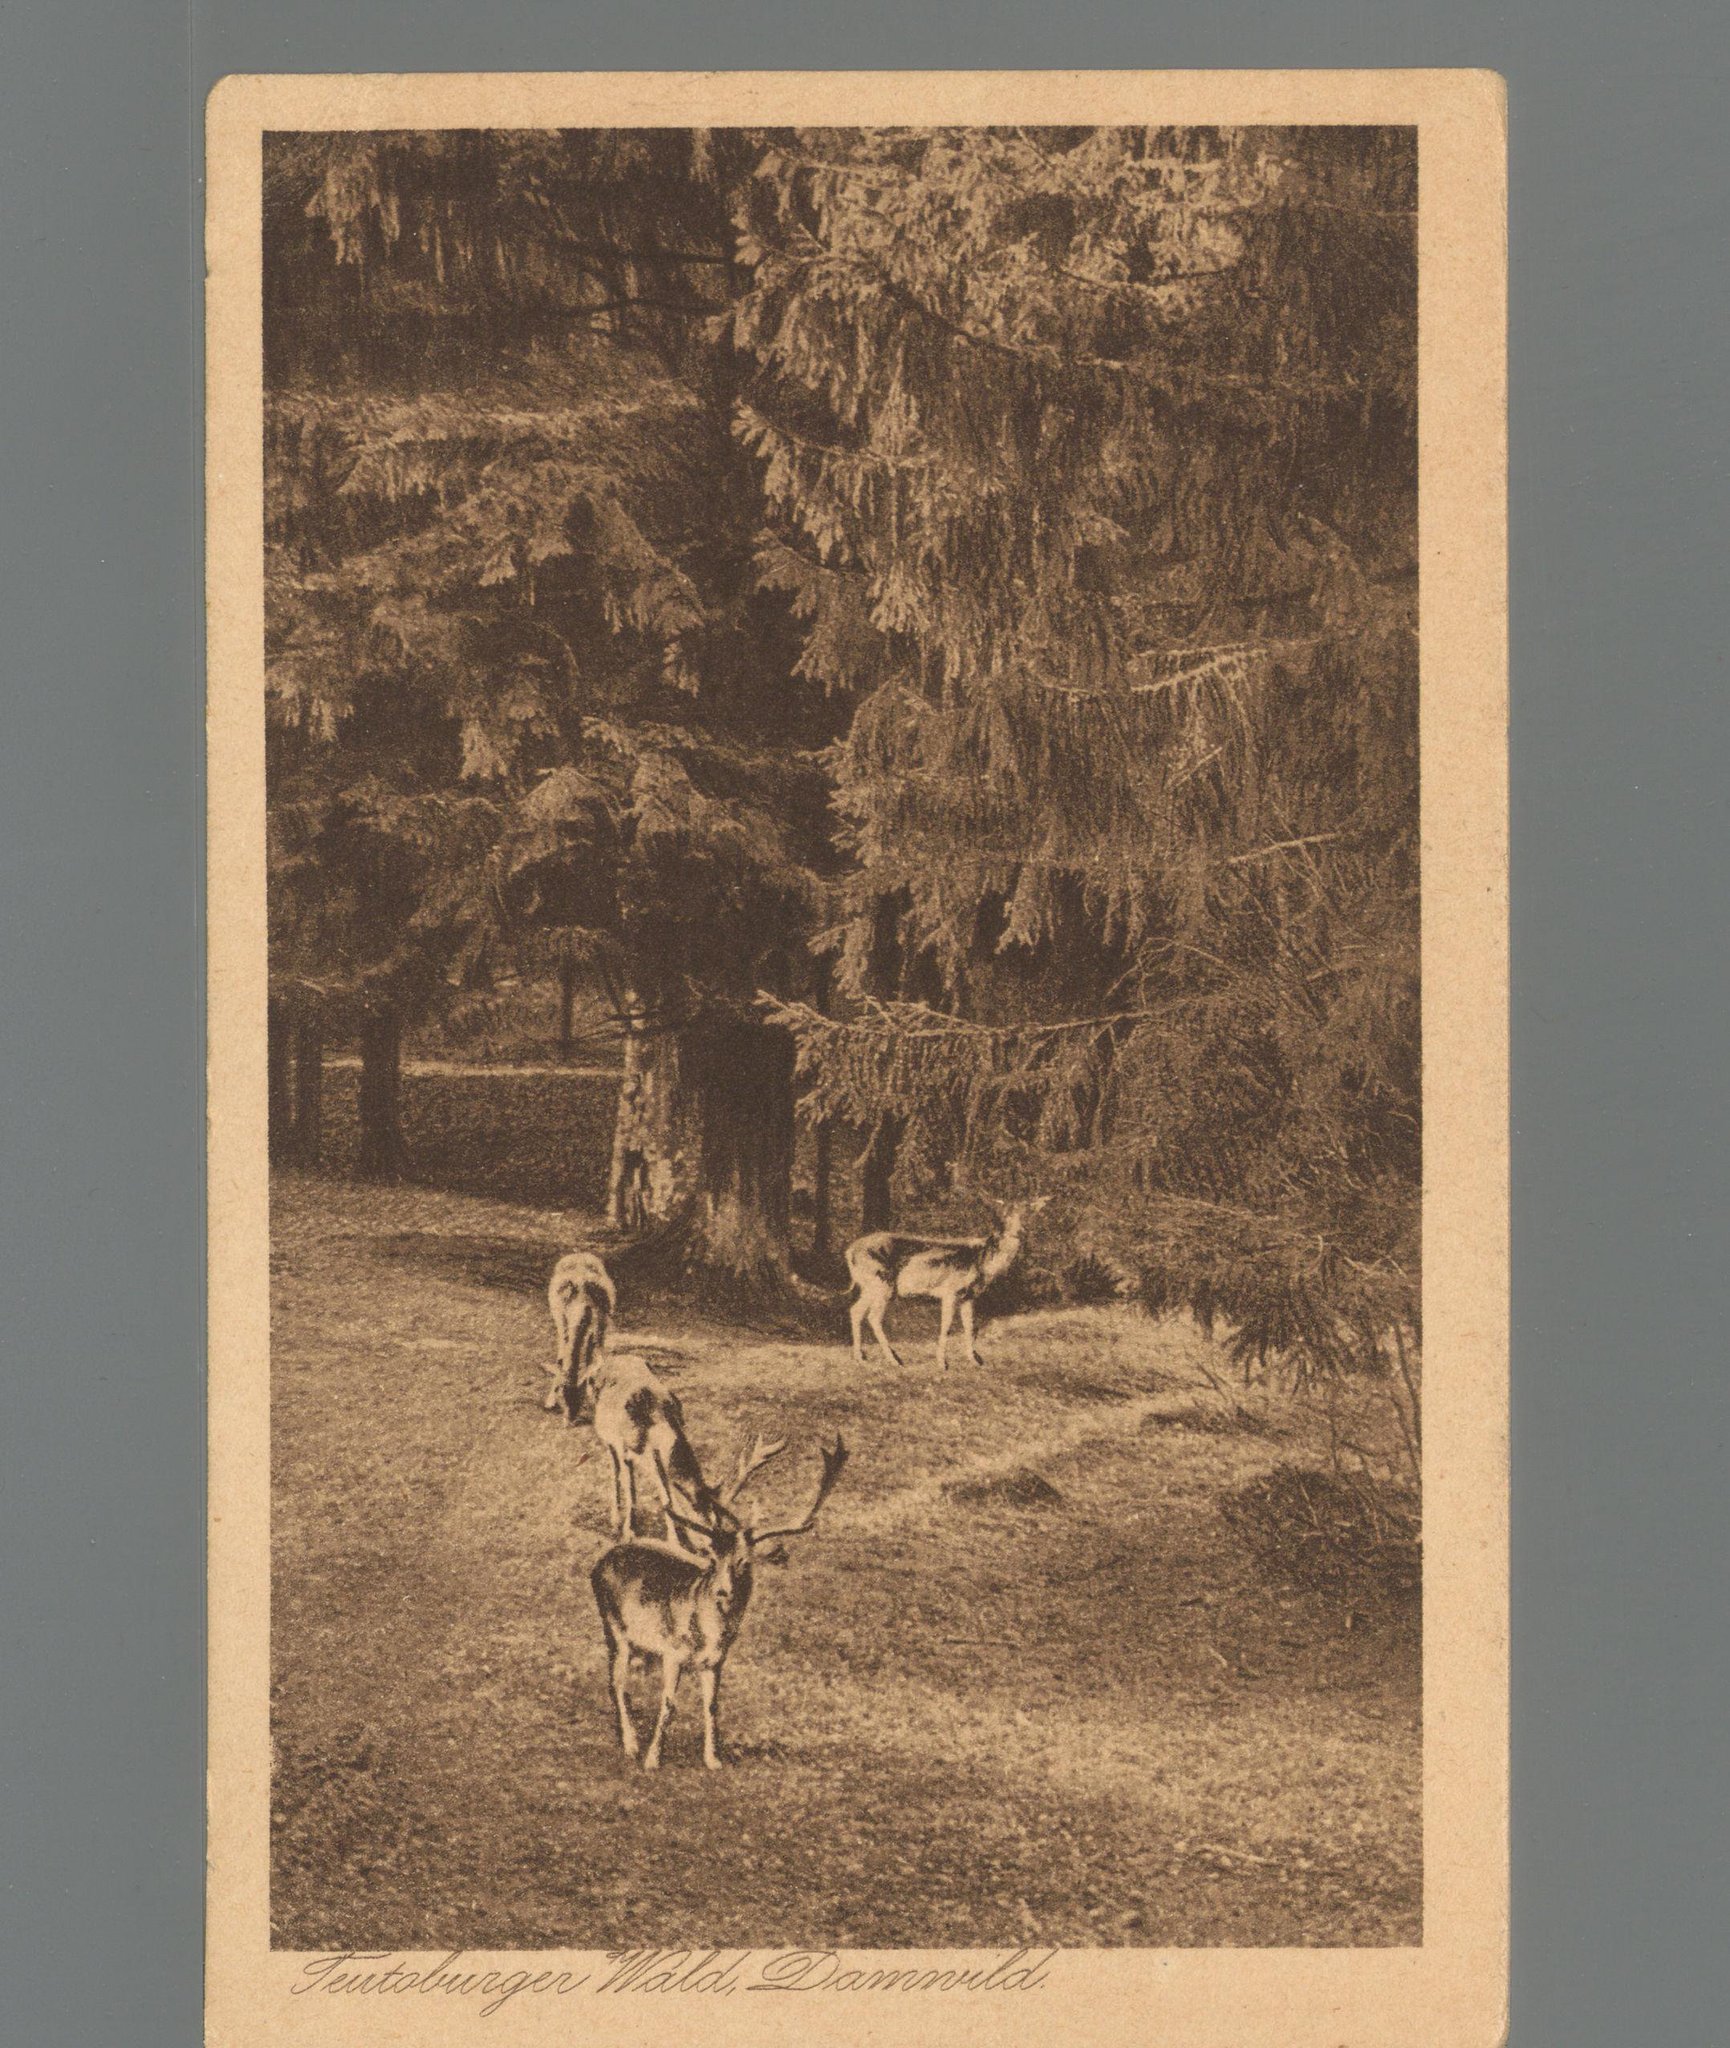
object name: photomechanical print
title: Teutoburger Wald, Damwild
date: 1905-1930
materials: cardboard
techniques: rotogravure, writing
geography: teutoburgerwoud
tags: hoofed animals: deer, forest, wood